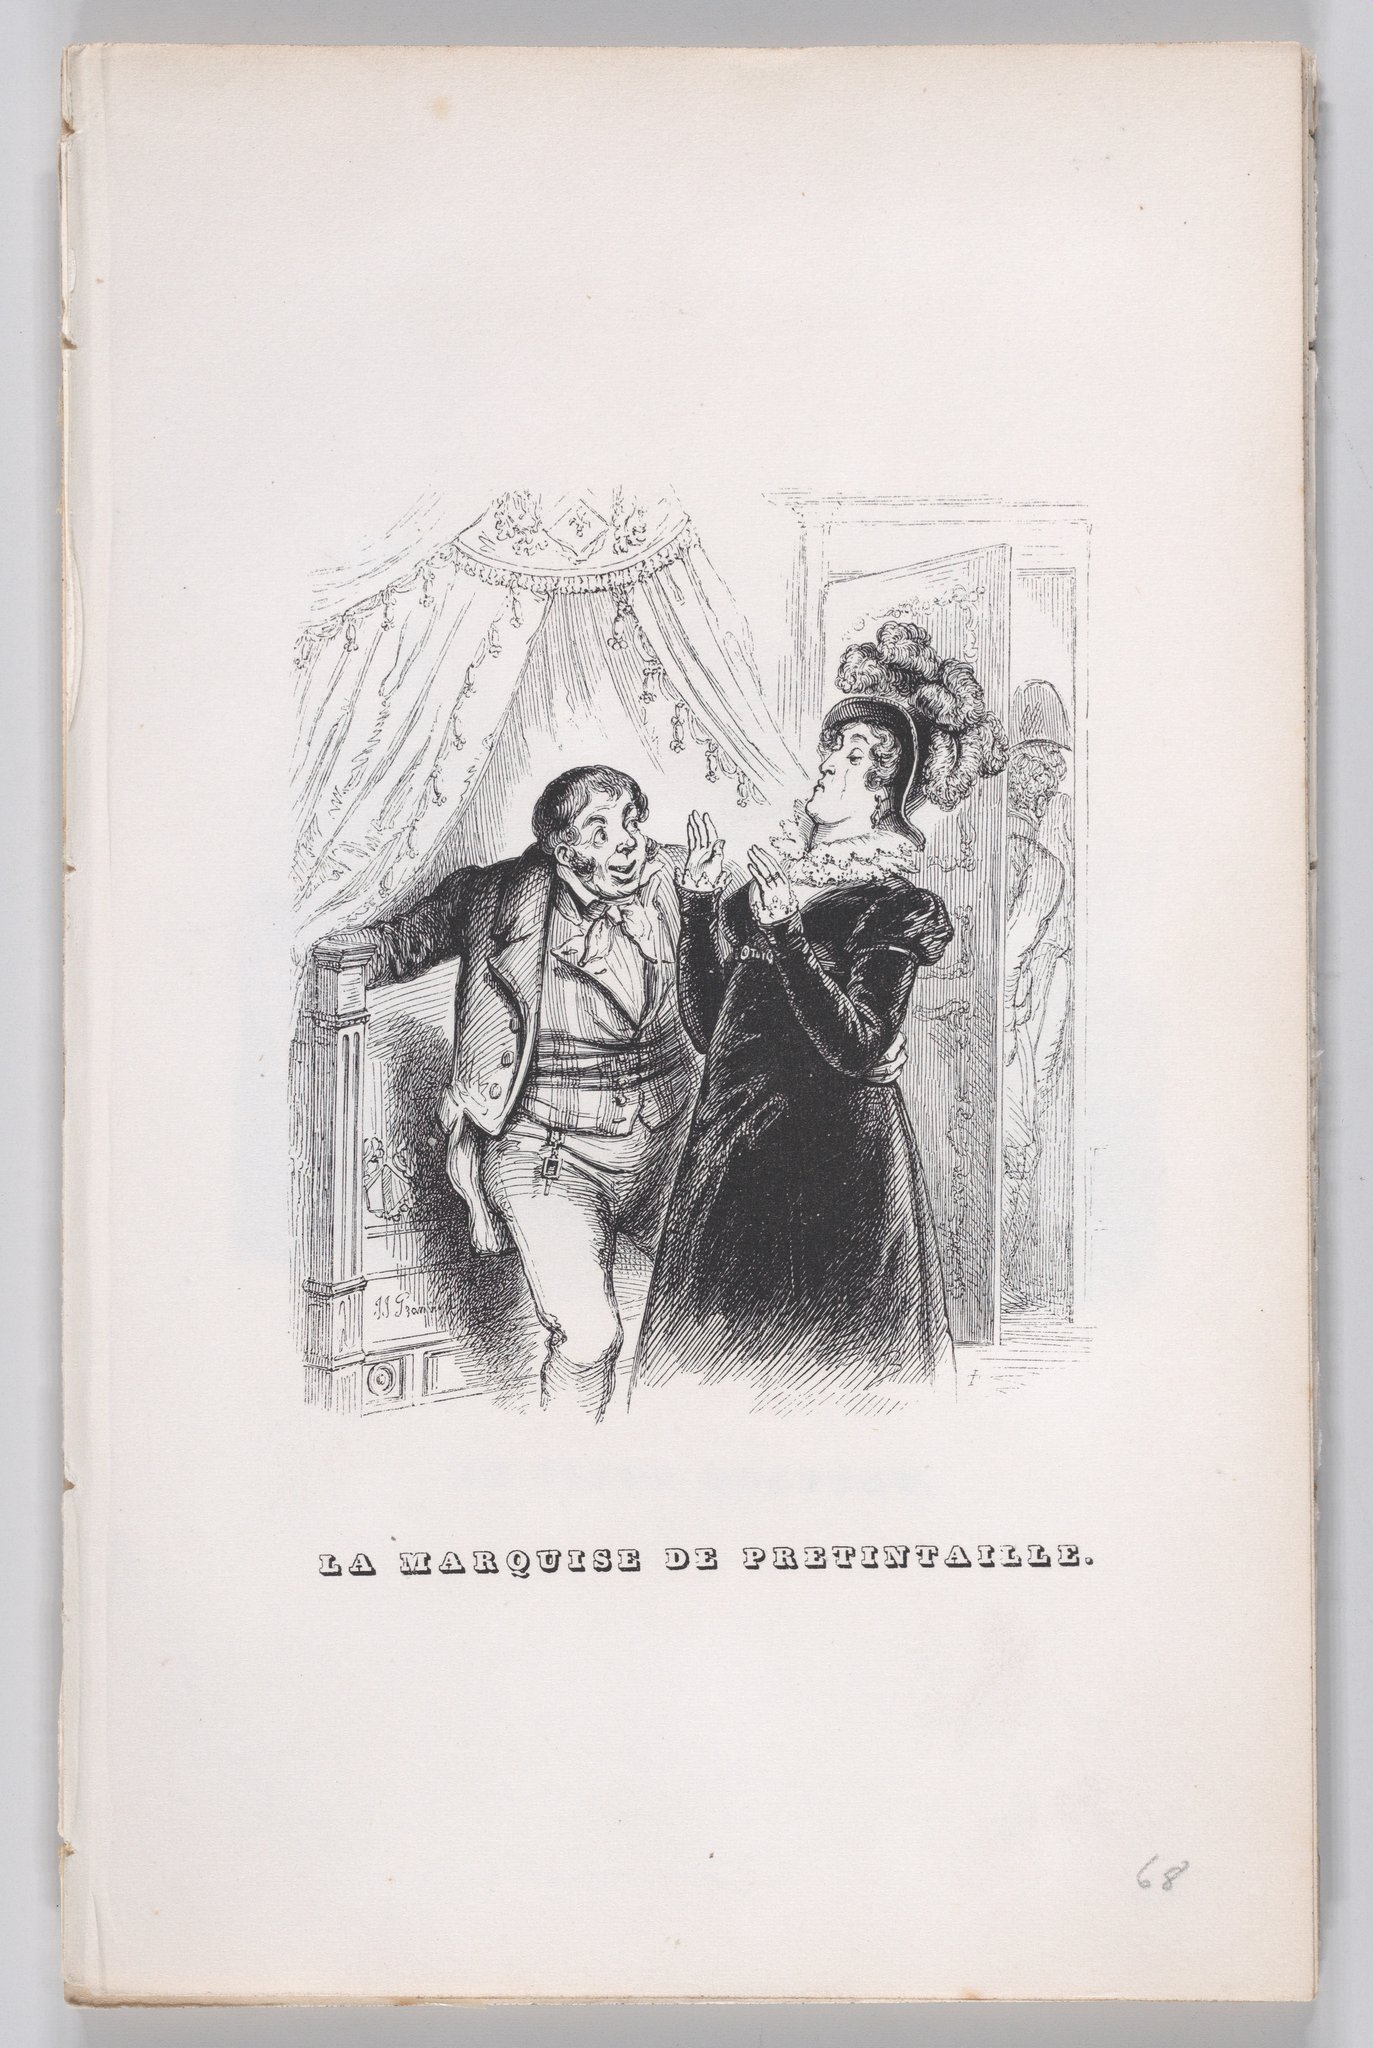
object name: print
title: The Marquise of Frivolty, from "The Complete Works of Béranger"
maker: j. j. grandville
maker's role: artist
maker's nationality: french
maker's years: 1803-1847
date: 1836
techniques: engraving